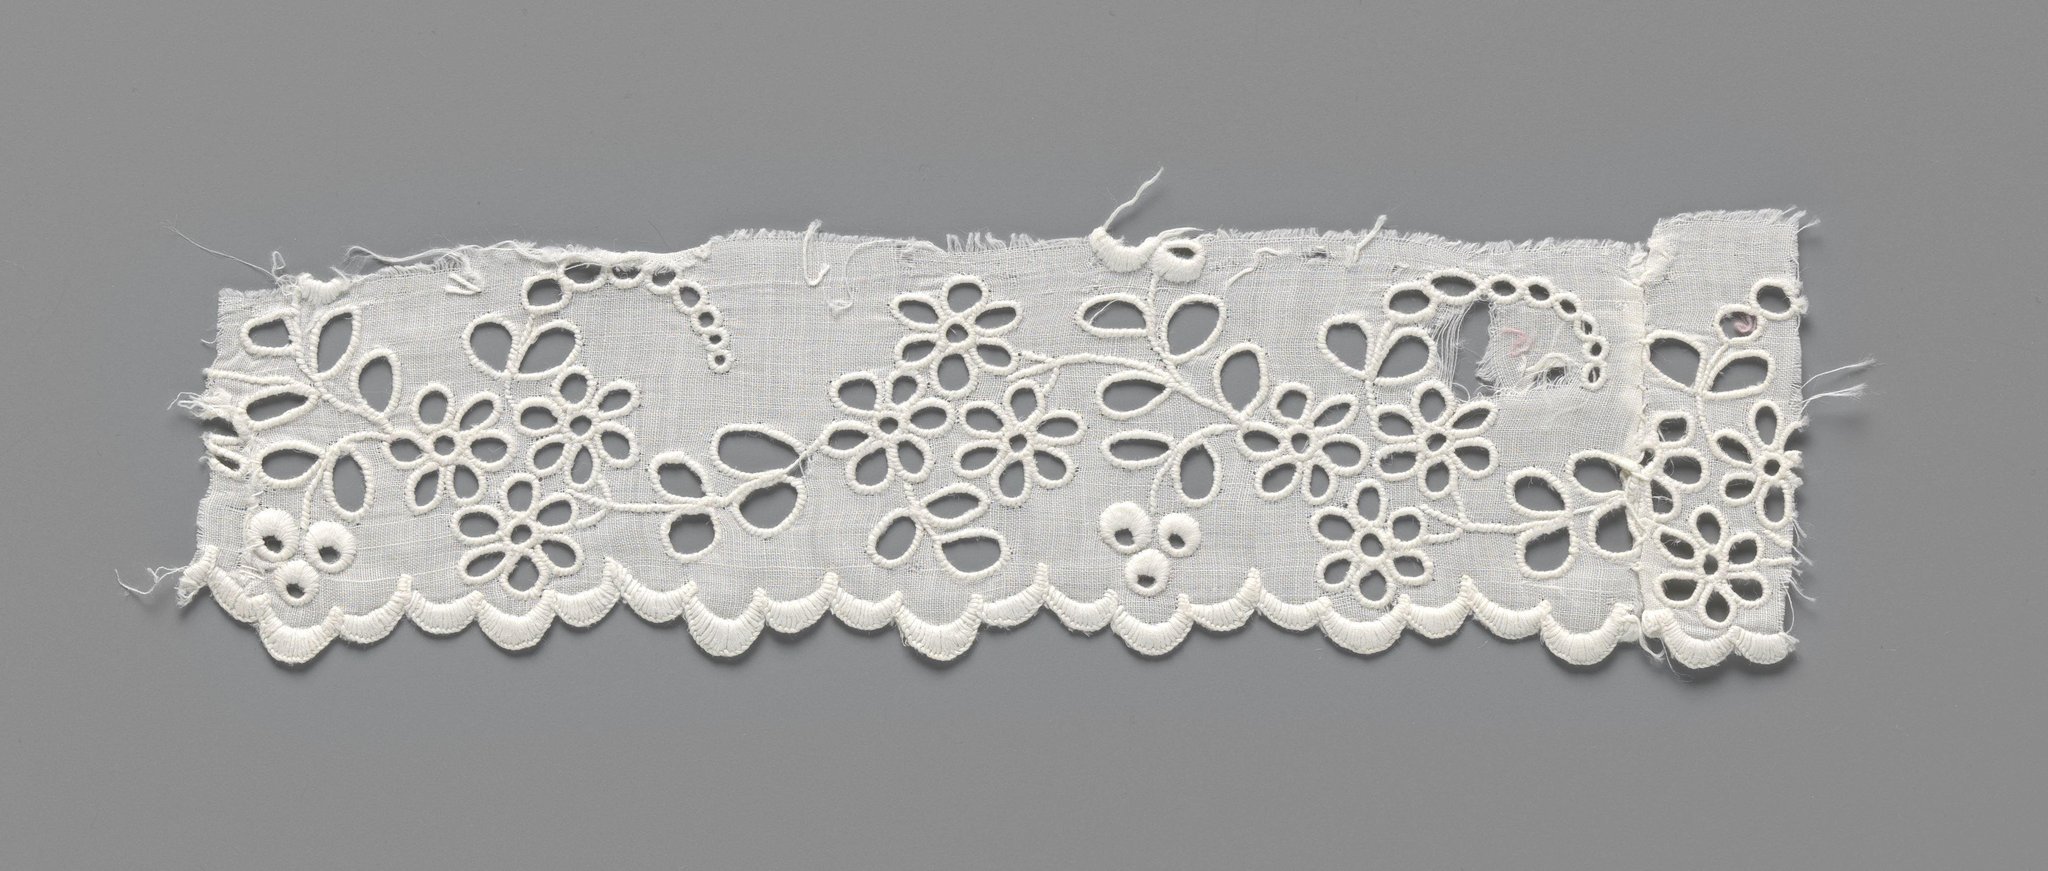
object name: strip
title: Strook katoen met kantborduurwerk met opengewerkte bloemen en bessen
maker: c.i. bosch reitz-teding van berkhout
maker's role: kantwerkster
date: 1860-1880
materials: cotton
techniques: weave, embroidery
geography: amsterdam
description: Strook naturelkleurig katoen met kantborduurwerk: Engels borduurwerk. De strook heeft een schulpenrand en een zich herhalend en doorlopend patroon met een golvende rank met opengewerkte bloemen, bladeren en bessen.